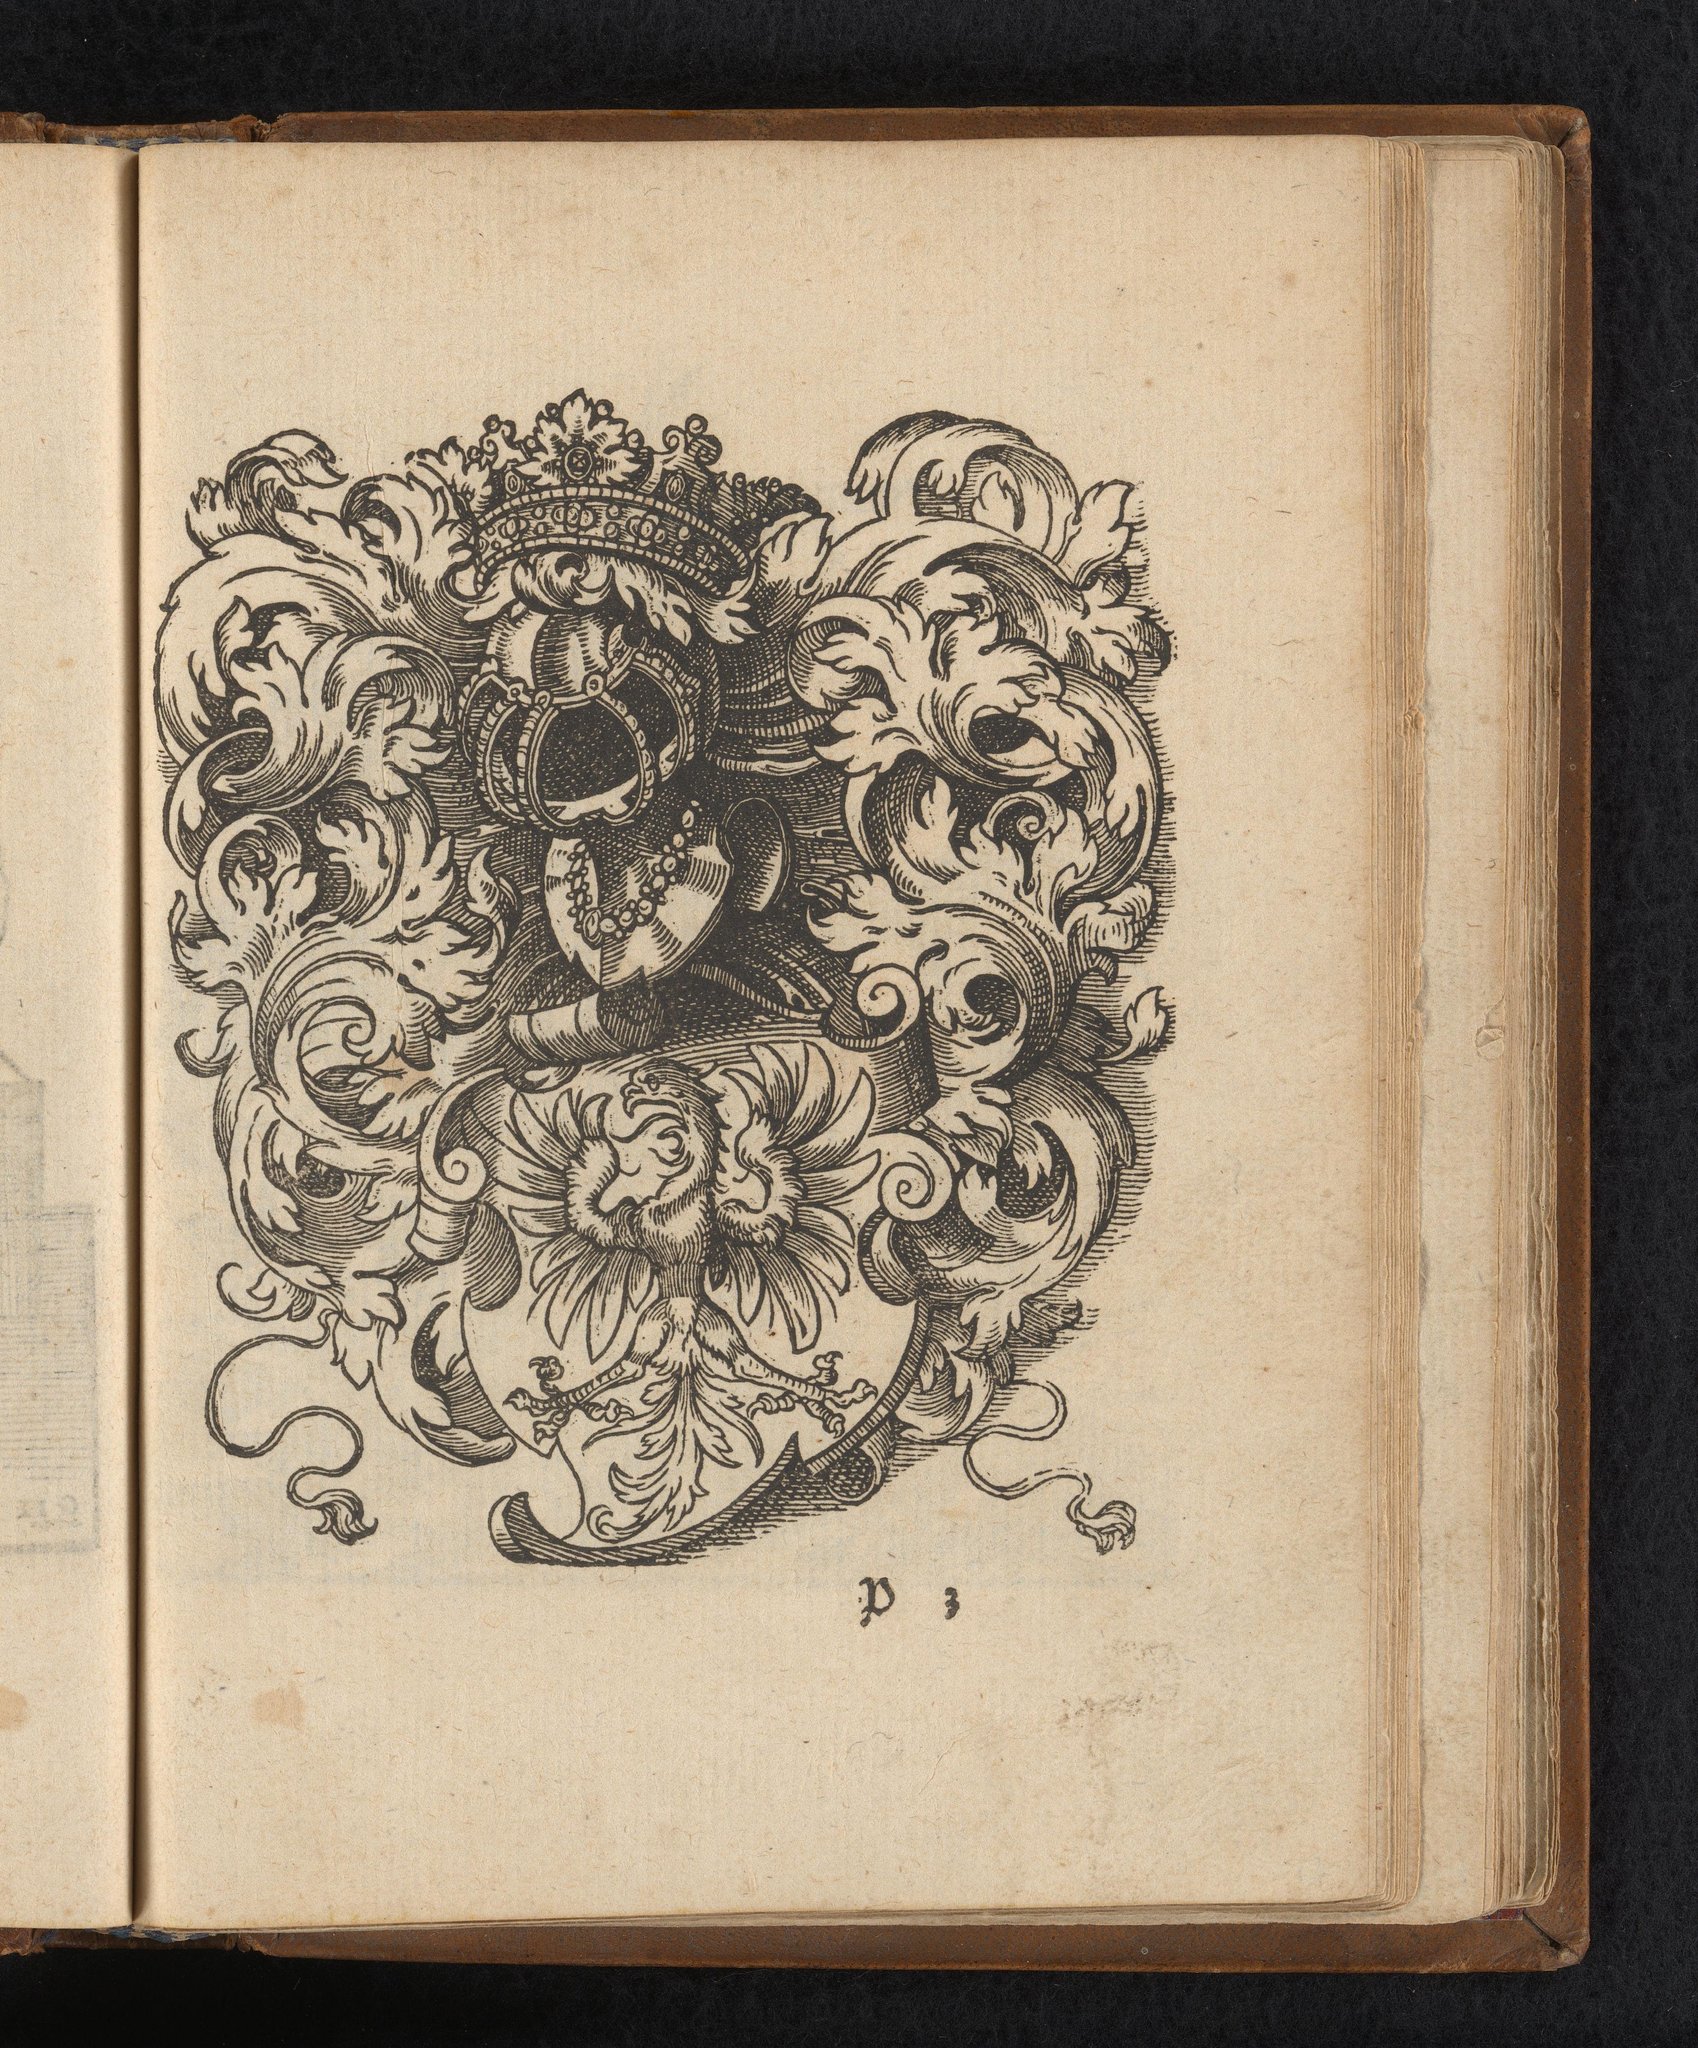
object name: print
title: Wapenschild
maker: Anonymous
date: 1578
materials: paper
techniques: woodcut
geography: nuremberg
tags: armorial bearing, heraldry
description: Wapenschild met adelaar, bladwerk en gekroonde helm. Onderdeel van het modelboek Enchiridion artis pingendi, fingendi & sculpendi met 108 figuren bedoeld voor beginnende schilders, beeldhouwers en prentmakers.